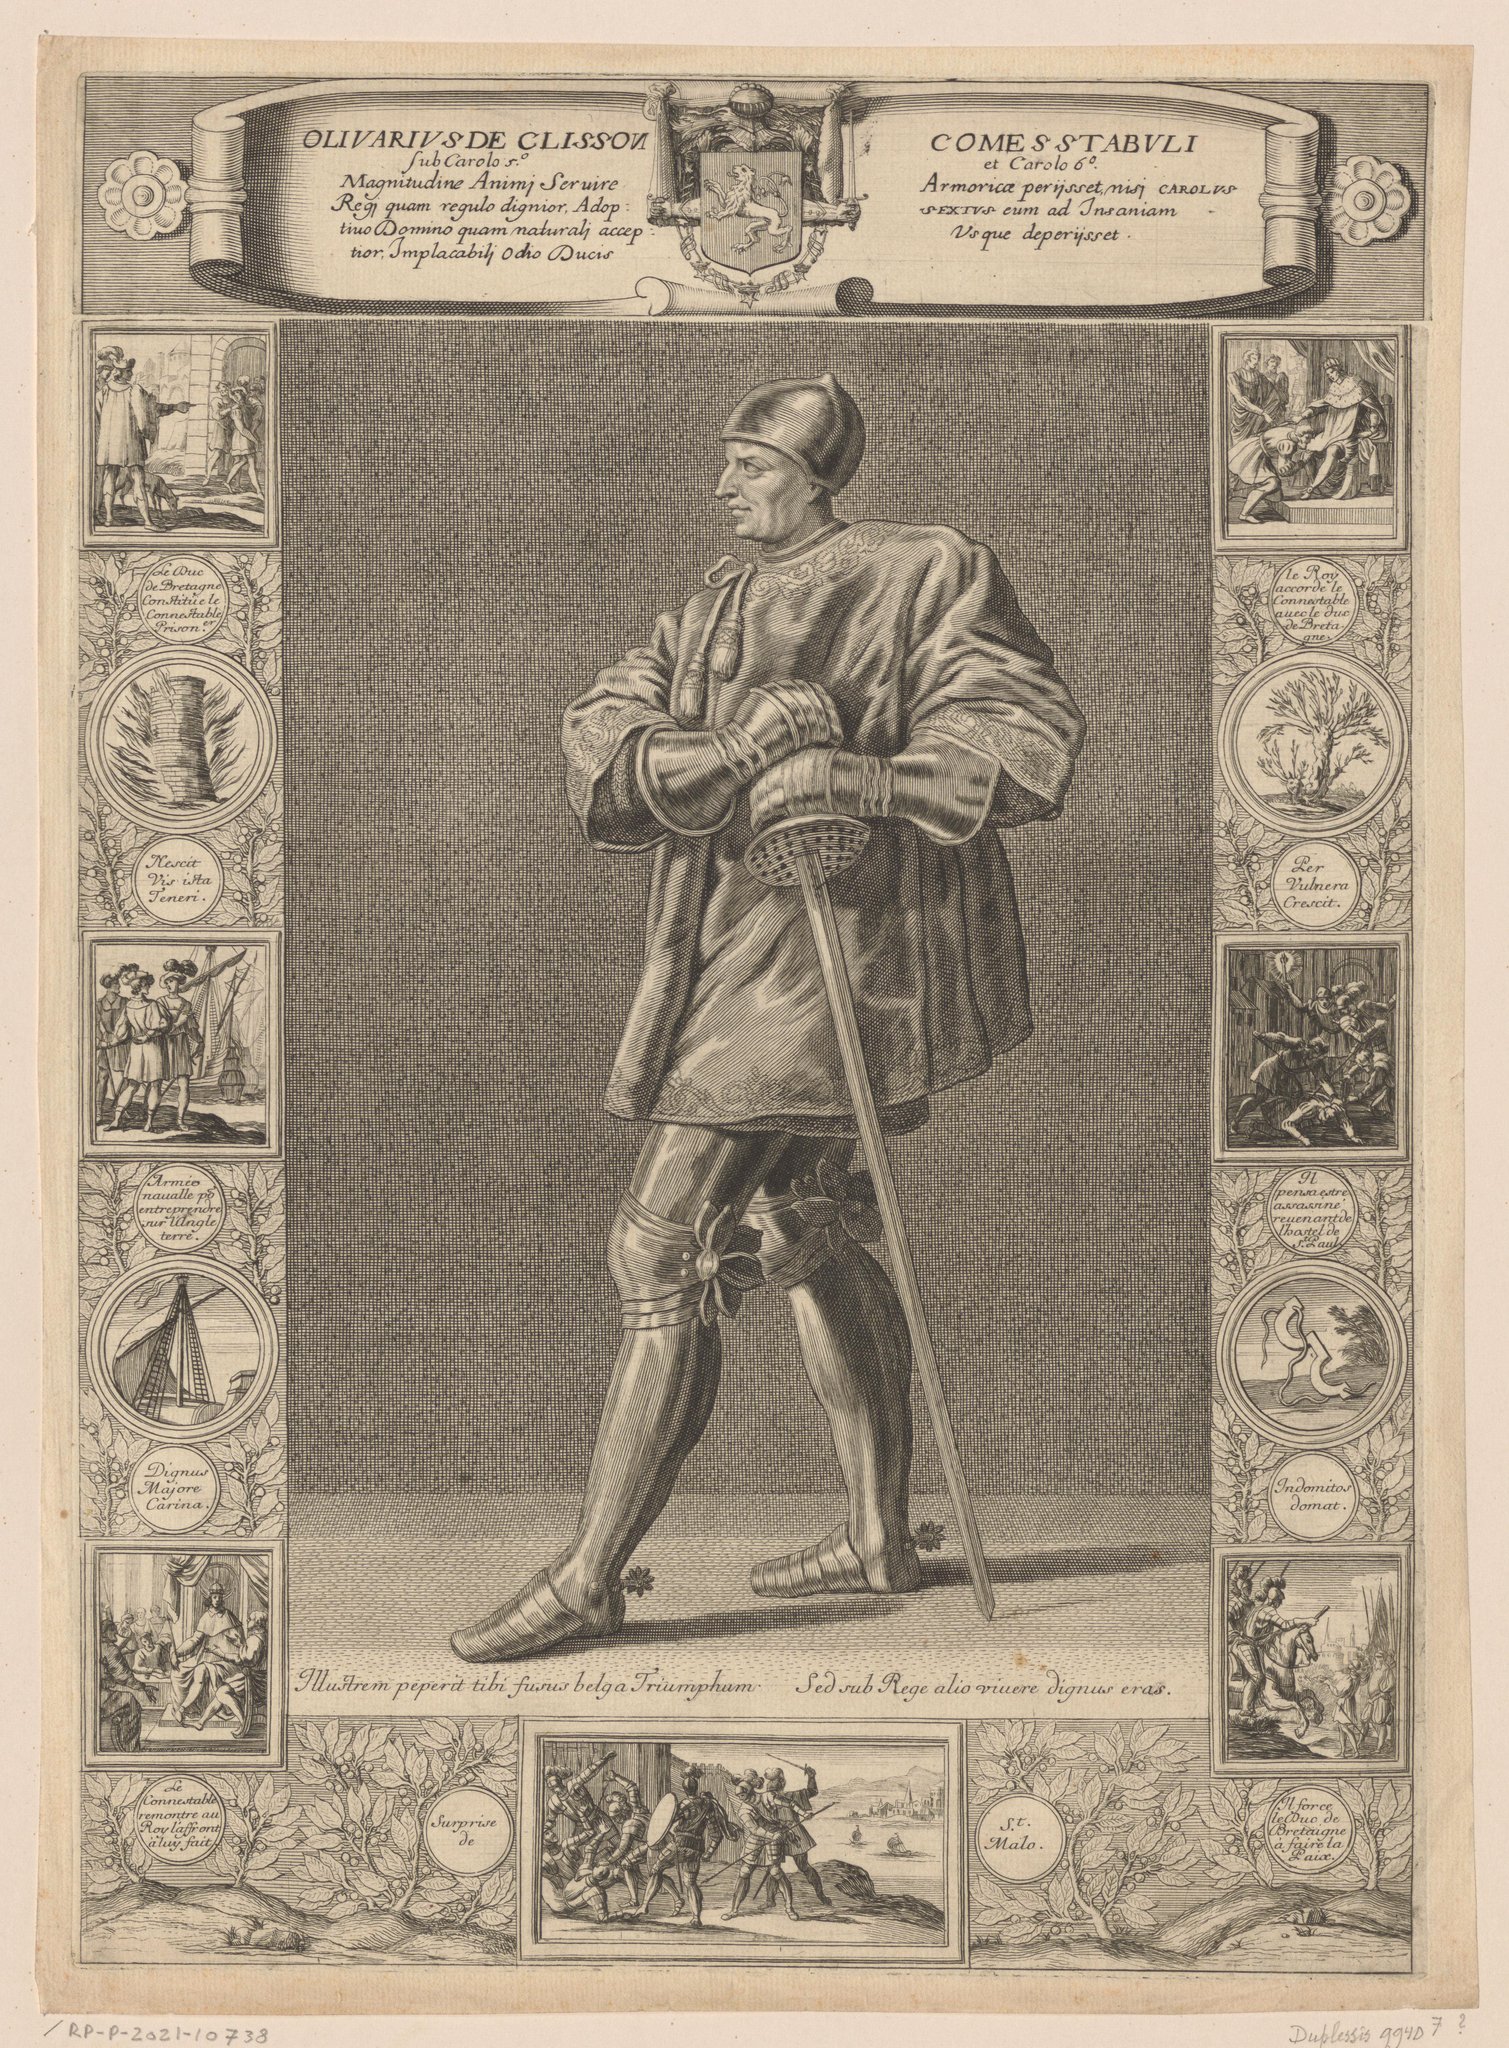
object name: print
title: Portret van Olivier V de Clisson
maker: françois bignon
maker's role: print maker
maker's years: 1620-1671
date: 1650-1690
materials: paper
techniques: engraving, etching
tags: standing figure, towers ~ fortified city, historical persons, battle, hacking and thrusting weapons: sword, trees: olive-tree, trees: willow, armorial bearing, heraldry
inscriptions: collector's mark: Lugt 2228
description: Prent mogelijk uit: Vulson de La Colombière, Marc de. Les portraits des hommes illustres François qui sont peints dans la gallerie du Palais cardinal de Richelieu (...). Parijs: Henry Sara et al., 1650. Of uit latere publicaties (1655, 1662, 1690 en 1690).